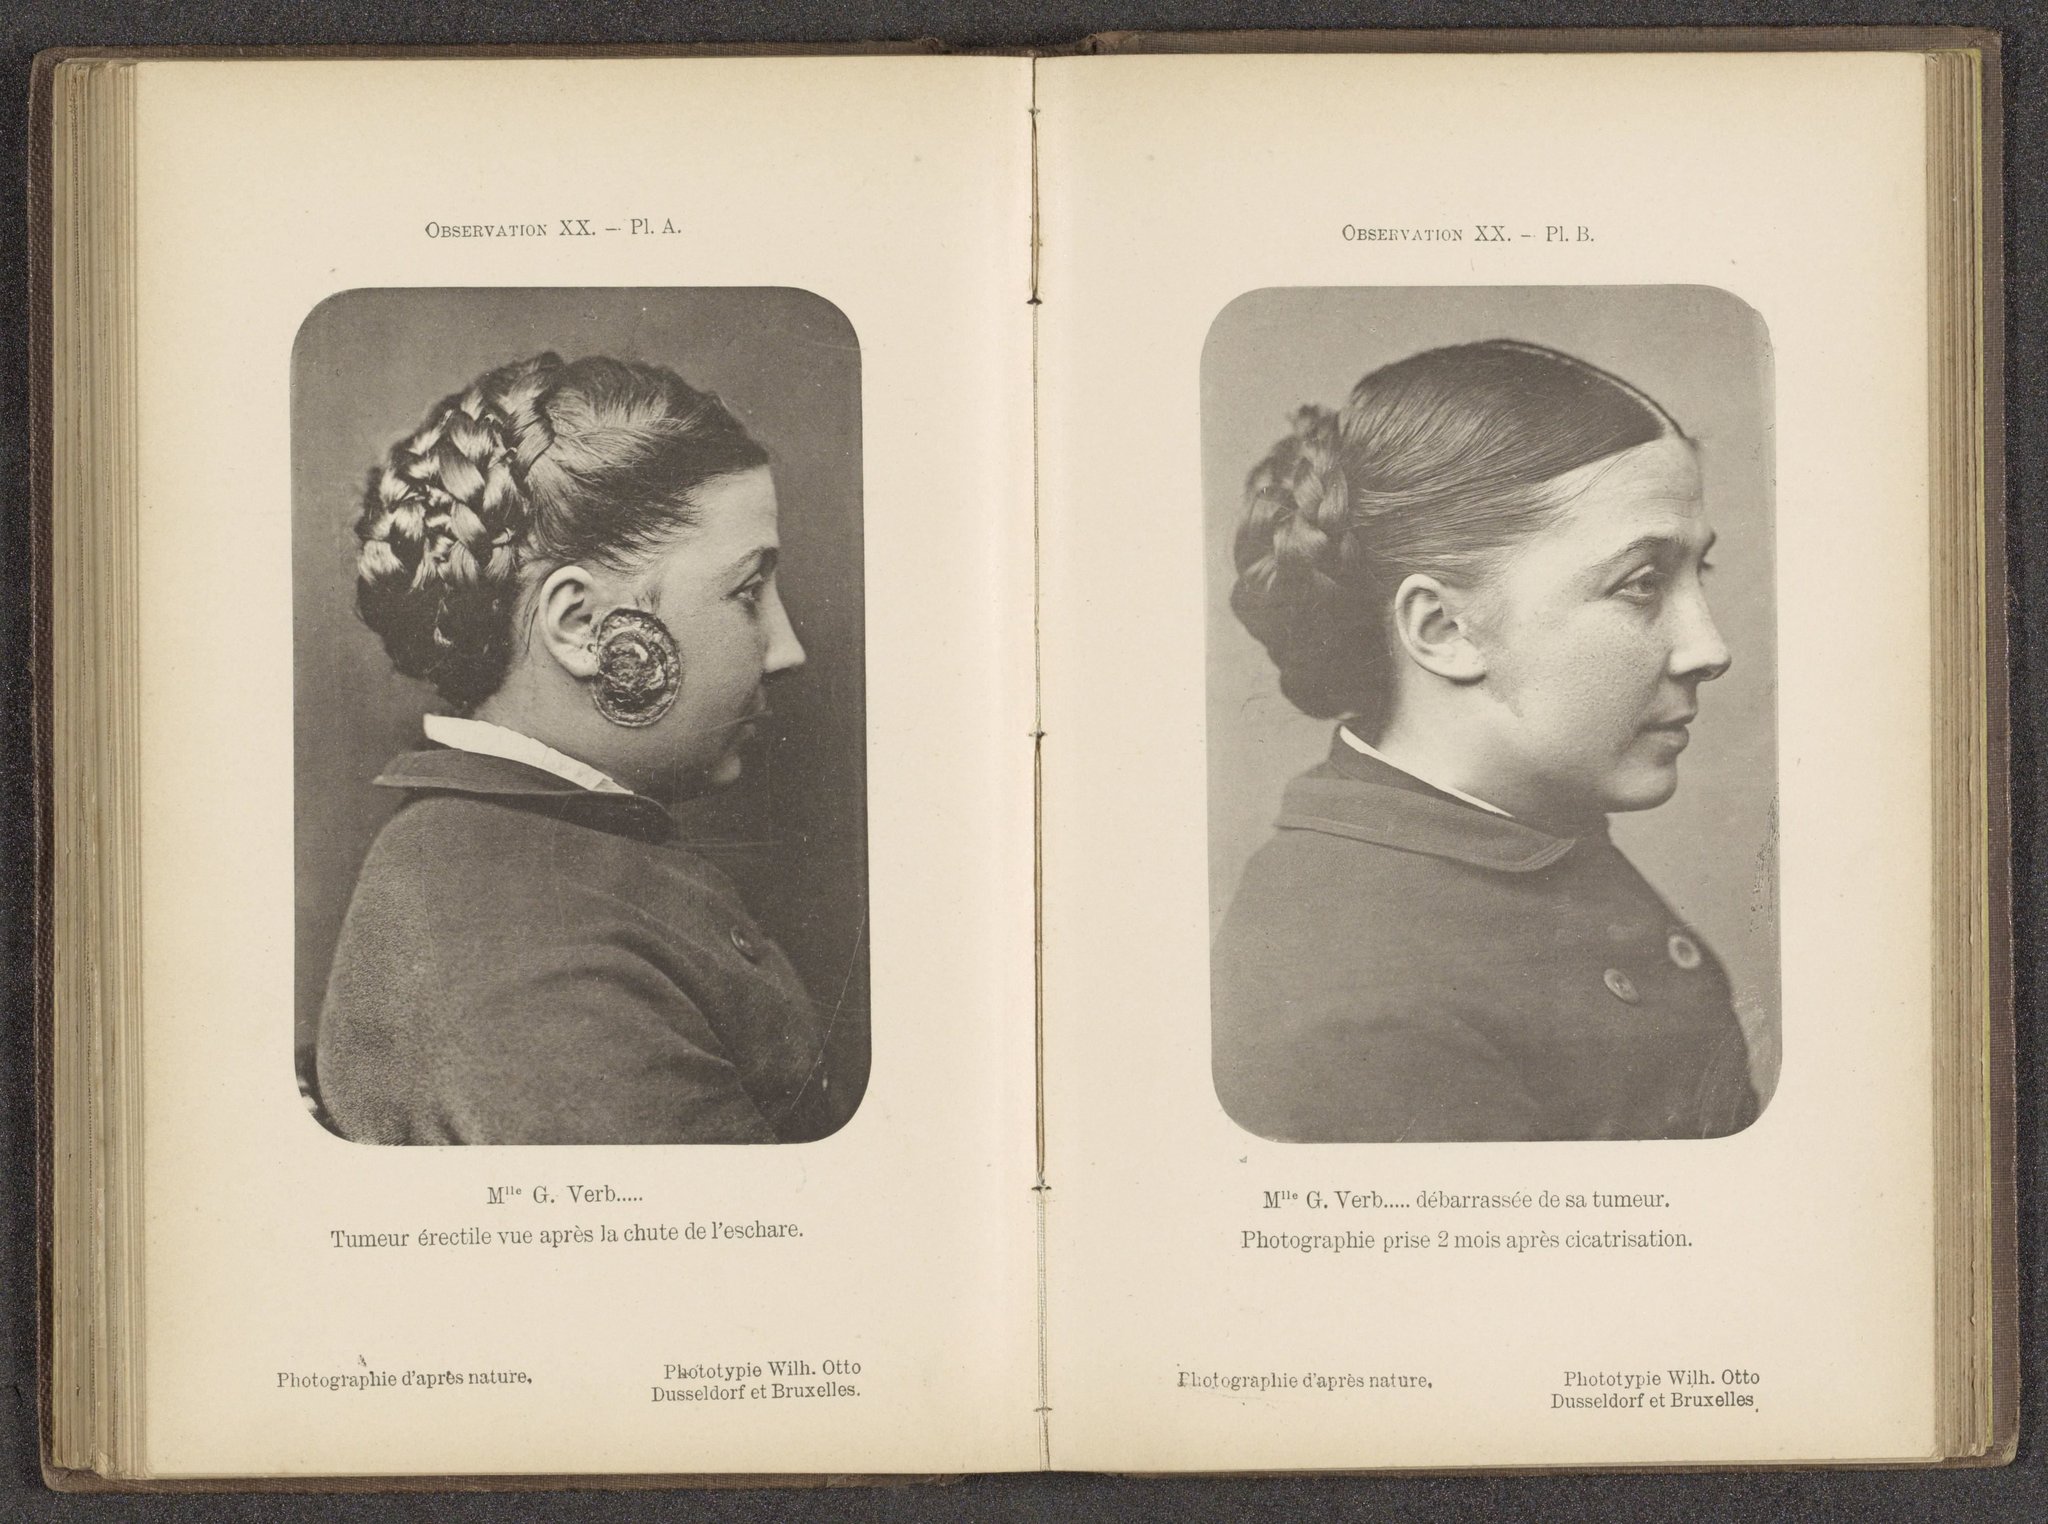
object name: page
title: Vrouw met een tumor naast haar oor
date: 1874-1884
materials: paper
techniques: photograph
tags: tumours - aa - female human figure, infections and wounds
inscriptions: inscription: ‘Observation XX. - Pl. A. / Mlle G. Verb.... / Tumeur érectile (...)’